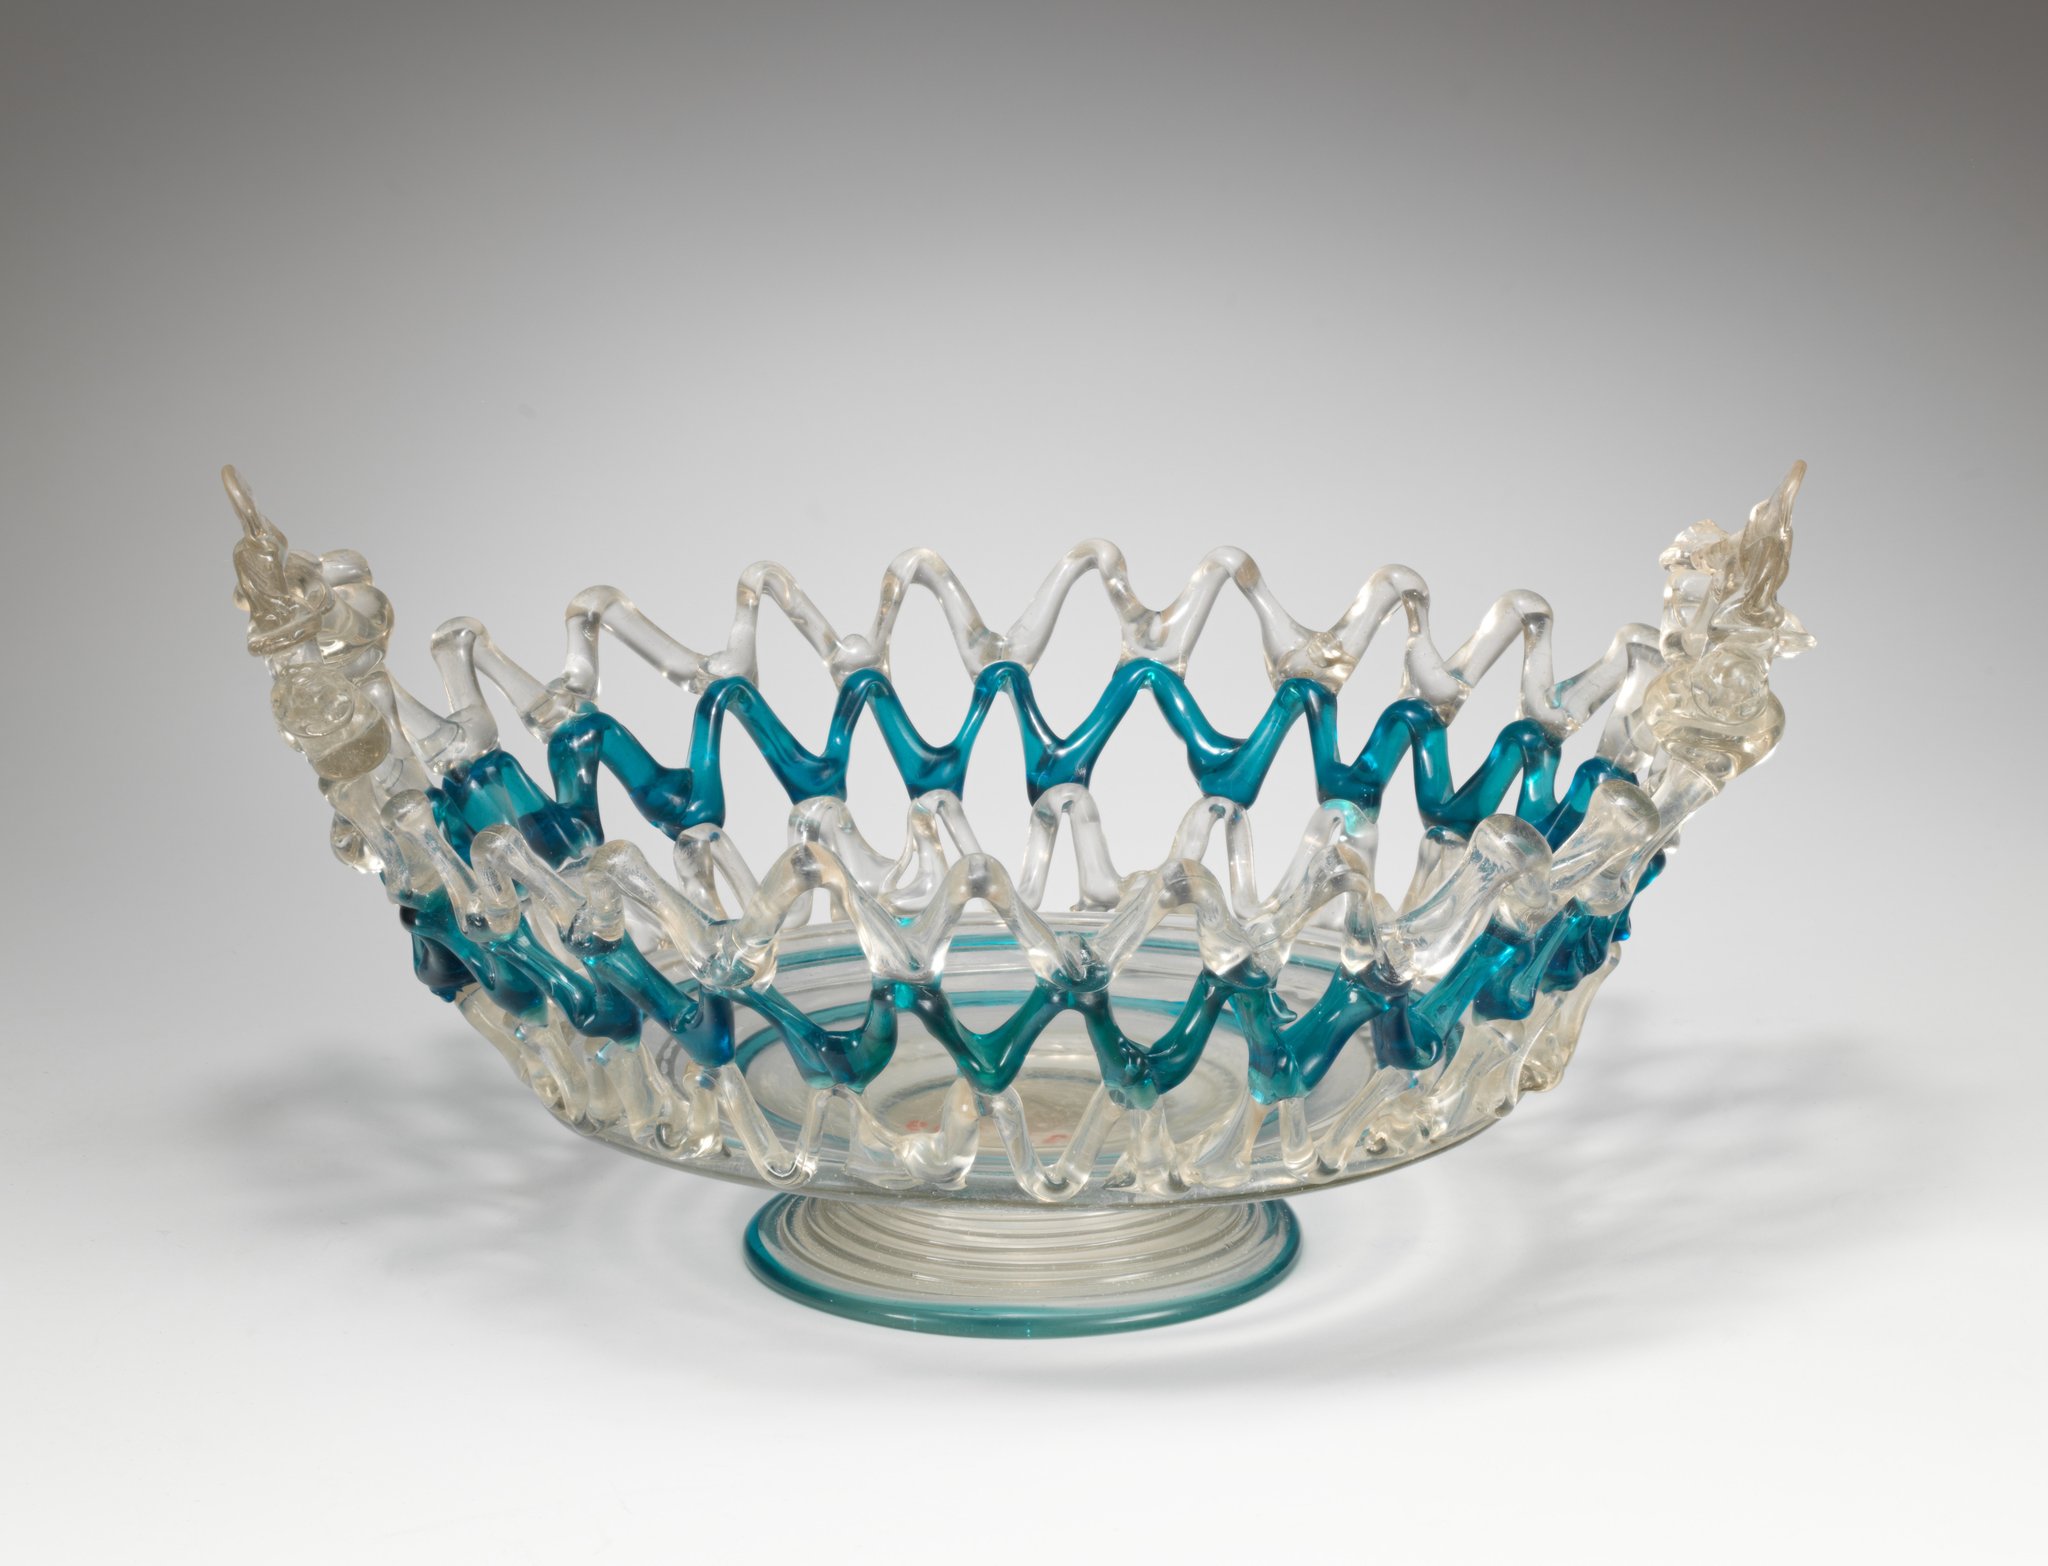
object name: dish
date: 1701-1750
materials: glass